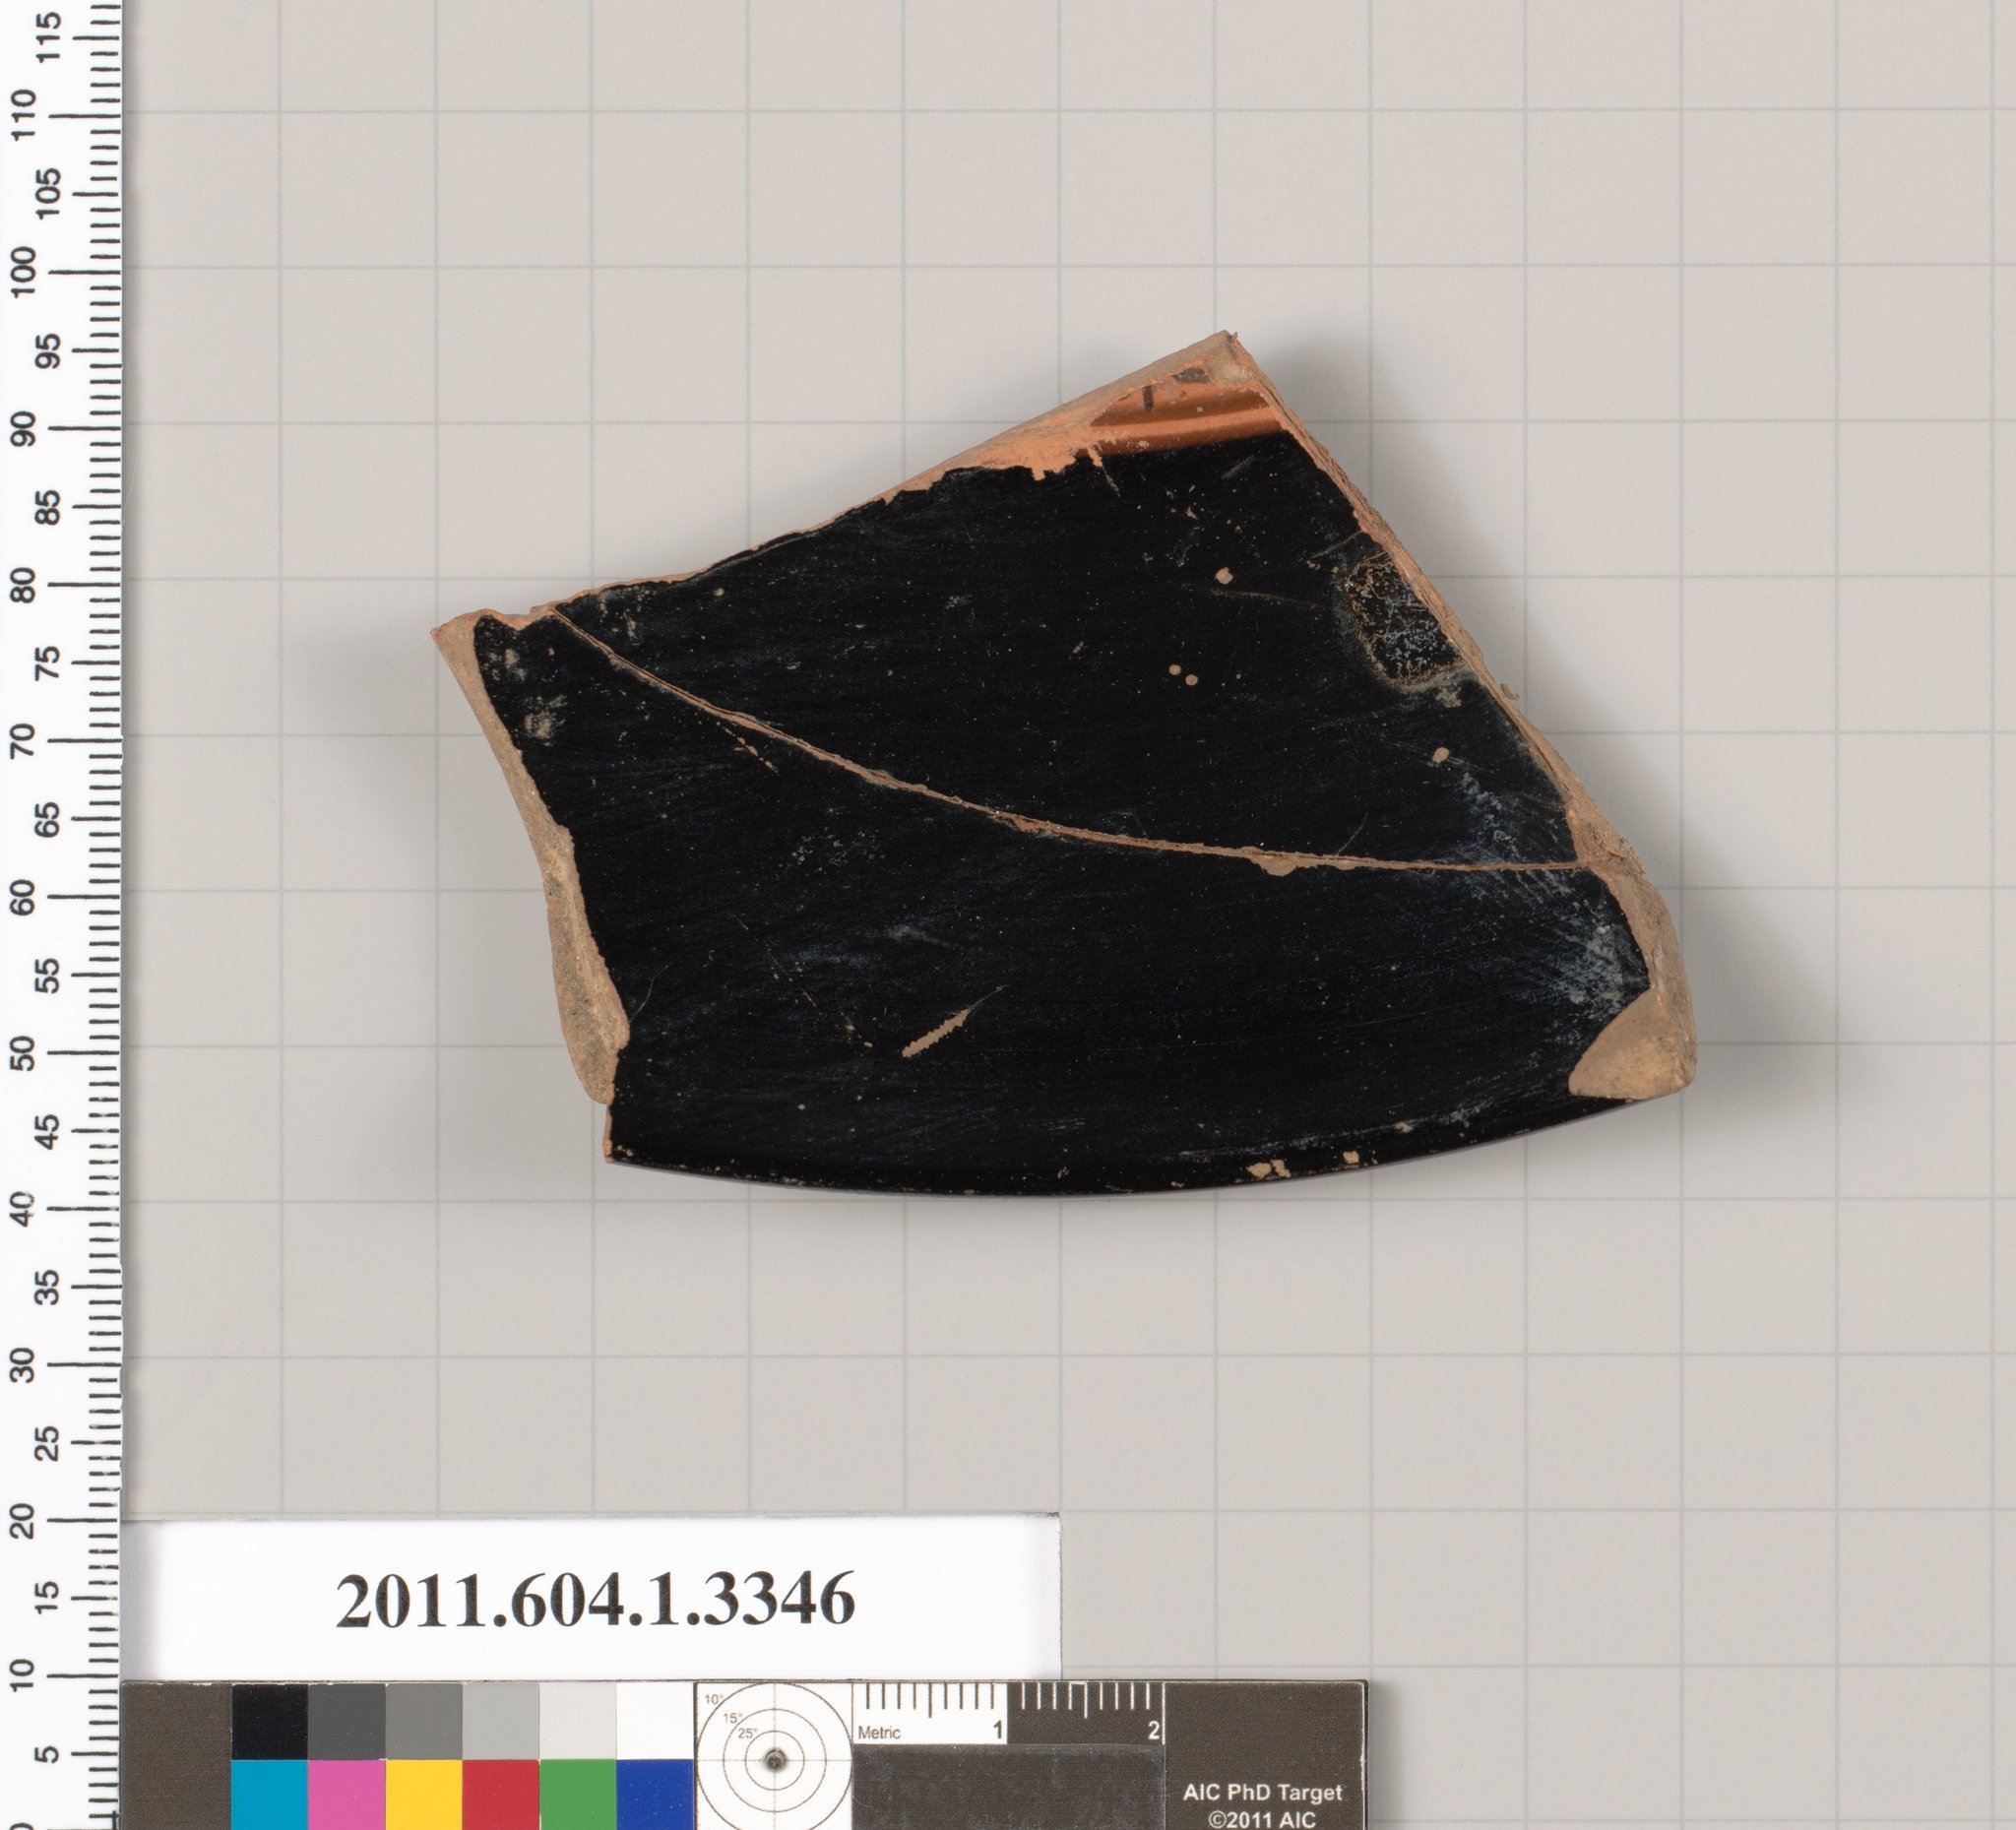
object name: kylix fragment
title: Terracotta fragment of a kylix (drinking cup)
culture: greek, attic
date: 500-470 BCE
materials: terracotta